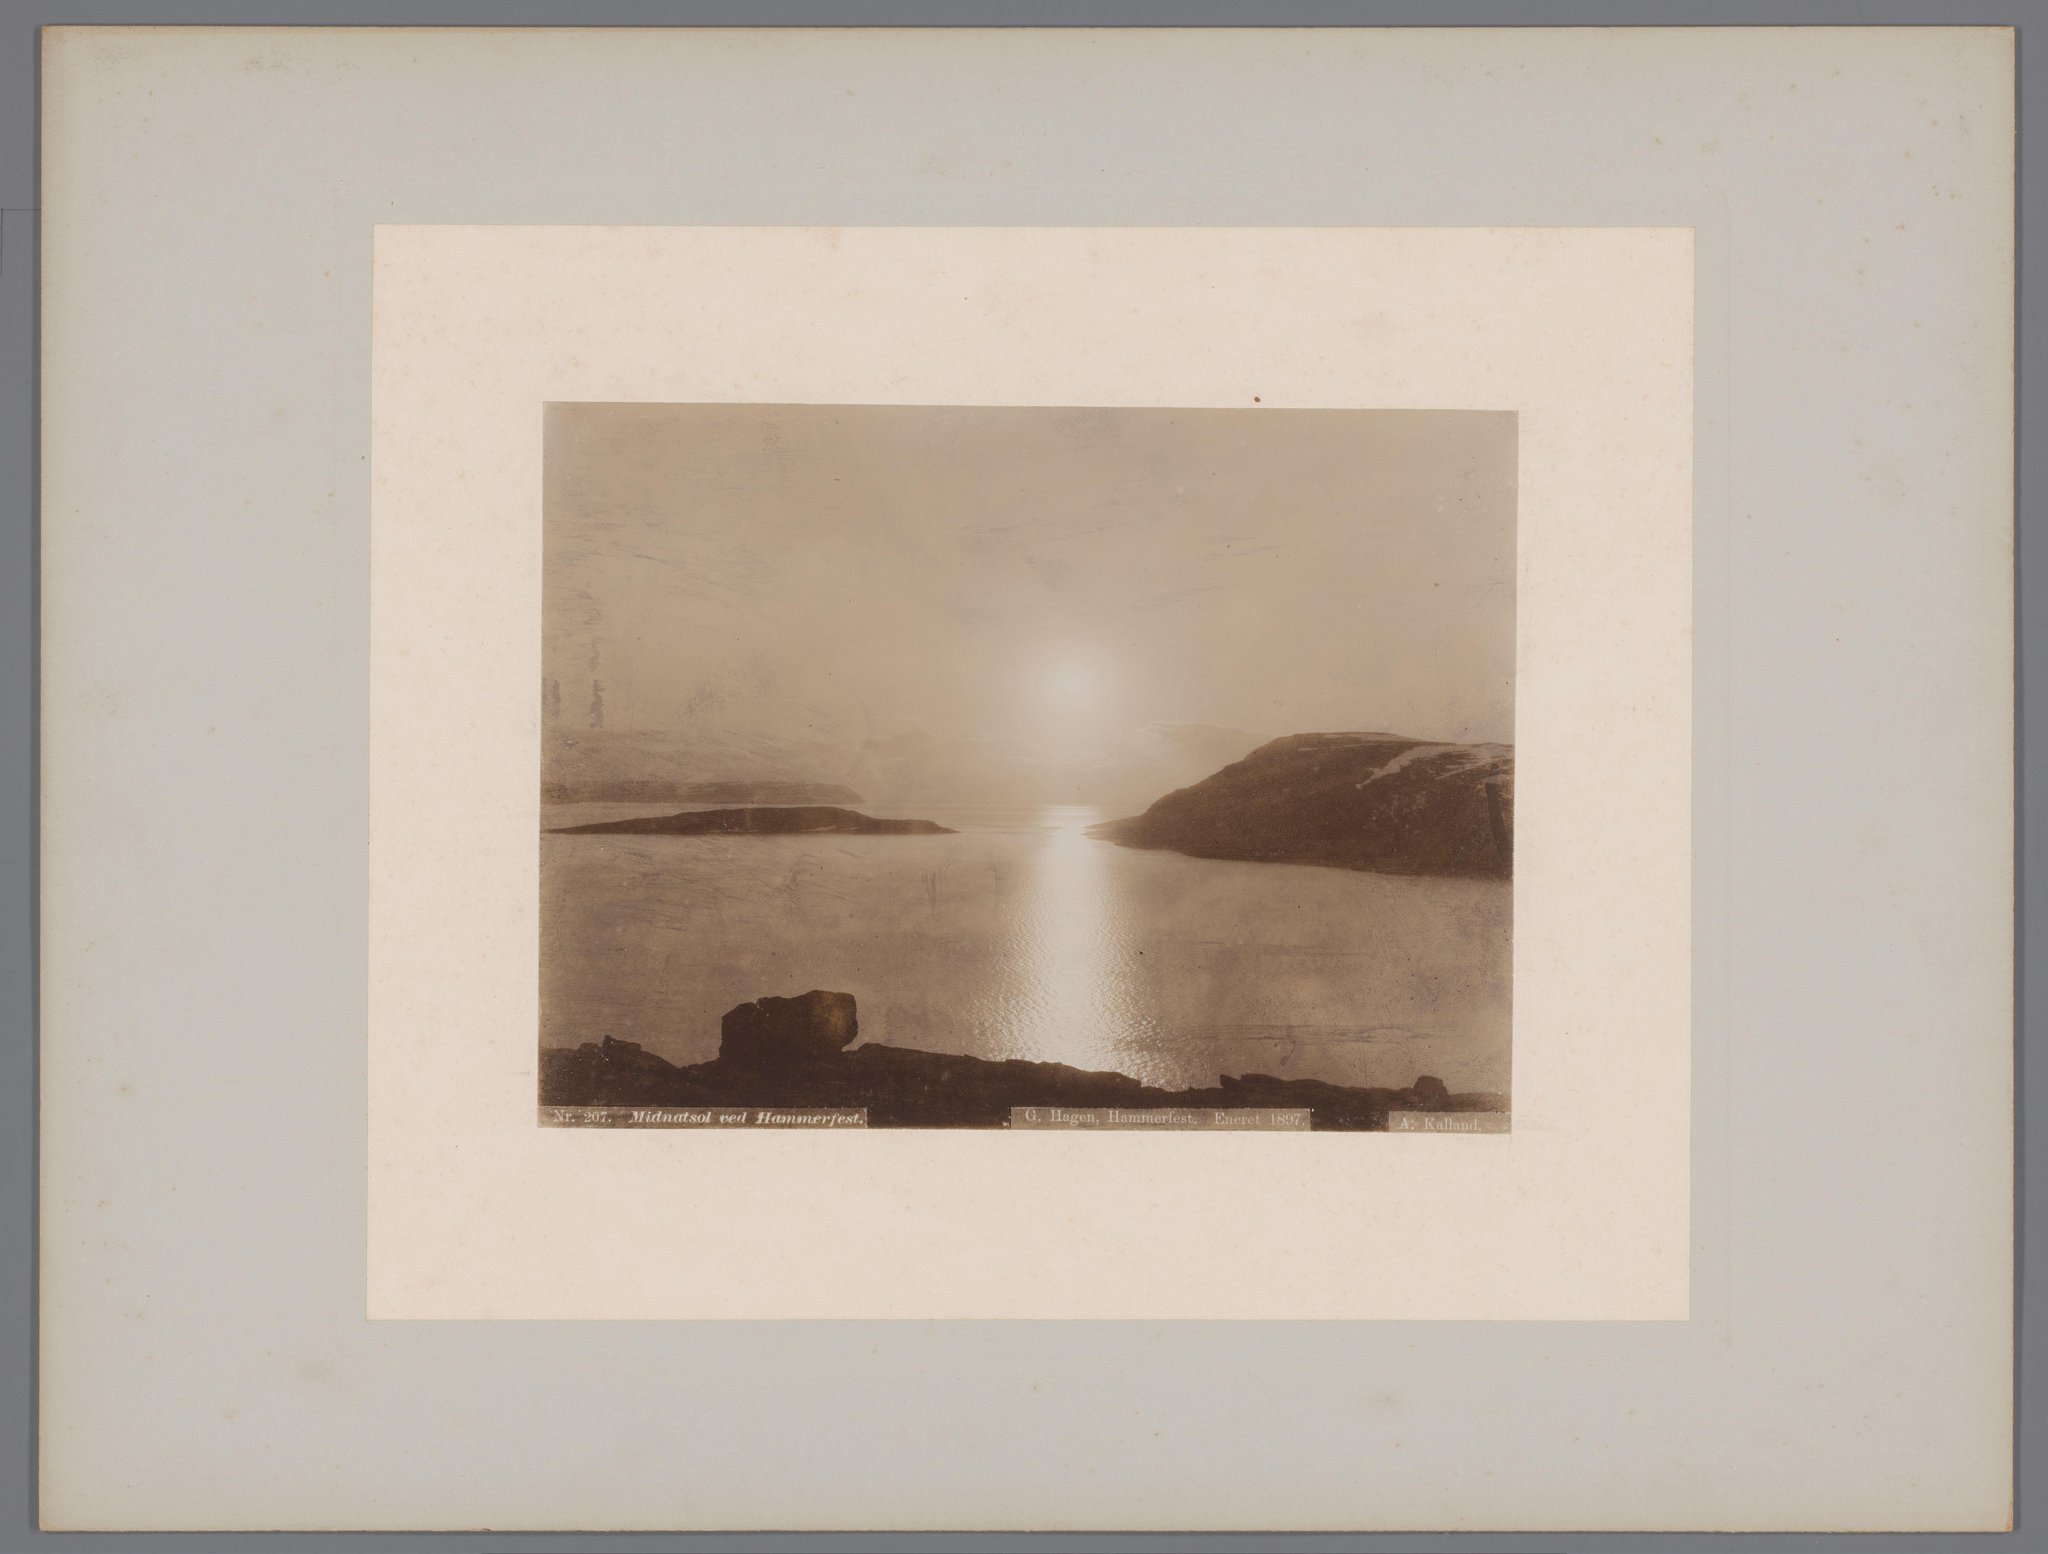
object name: photograph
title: Midnatsol ved Hammerfest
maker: anthon kalland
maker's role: painter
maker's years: 1856-1933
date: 1897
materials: cardboard, paper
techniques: albumen print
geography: hammerfest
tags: dawn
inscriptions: inscription: ‘Eneret’, number: ‘Nr. 207.’